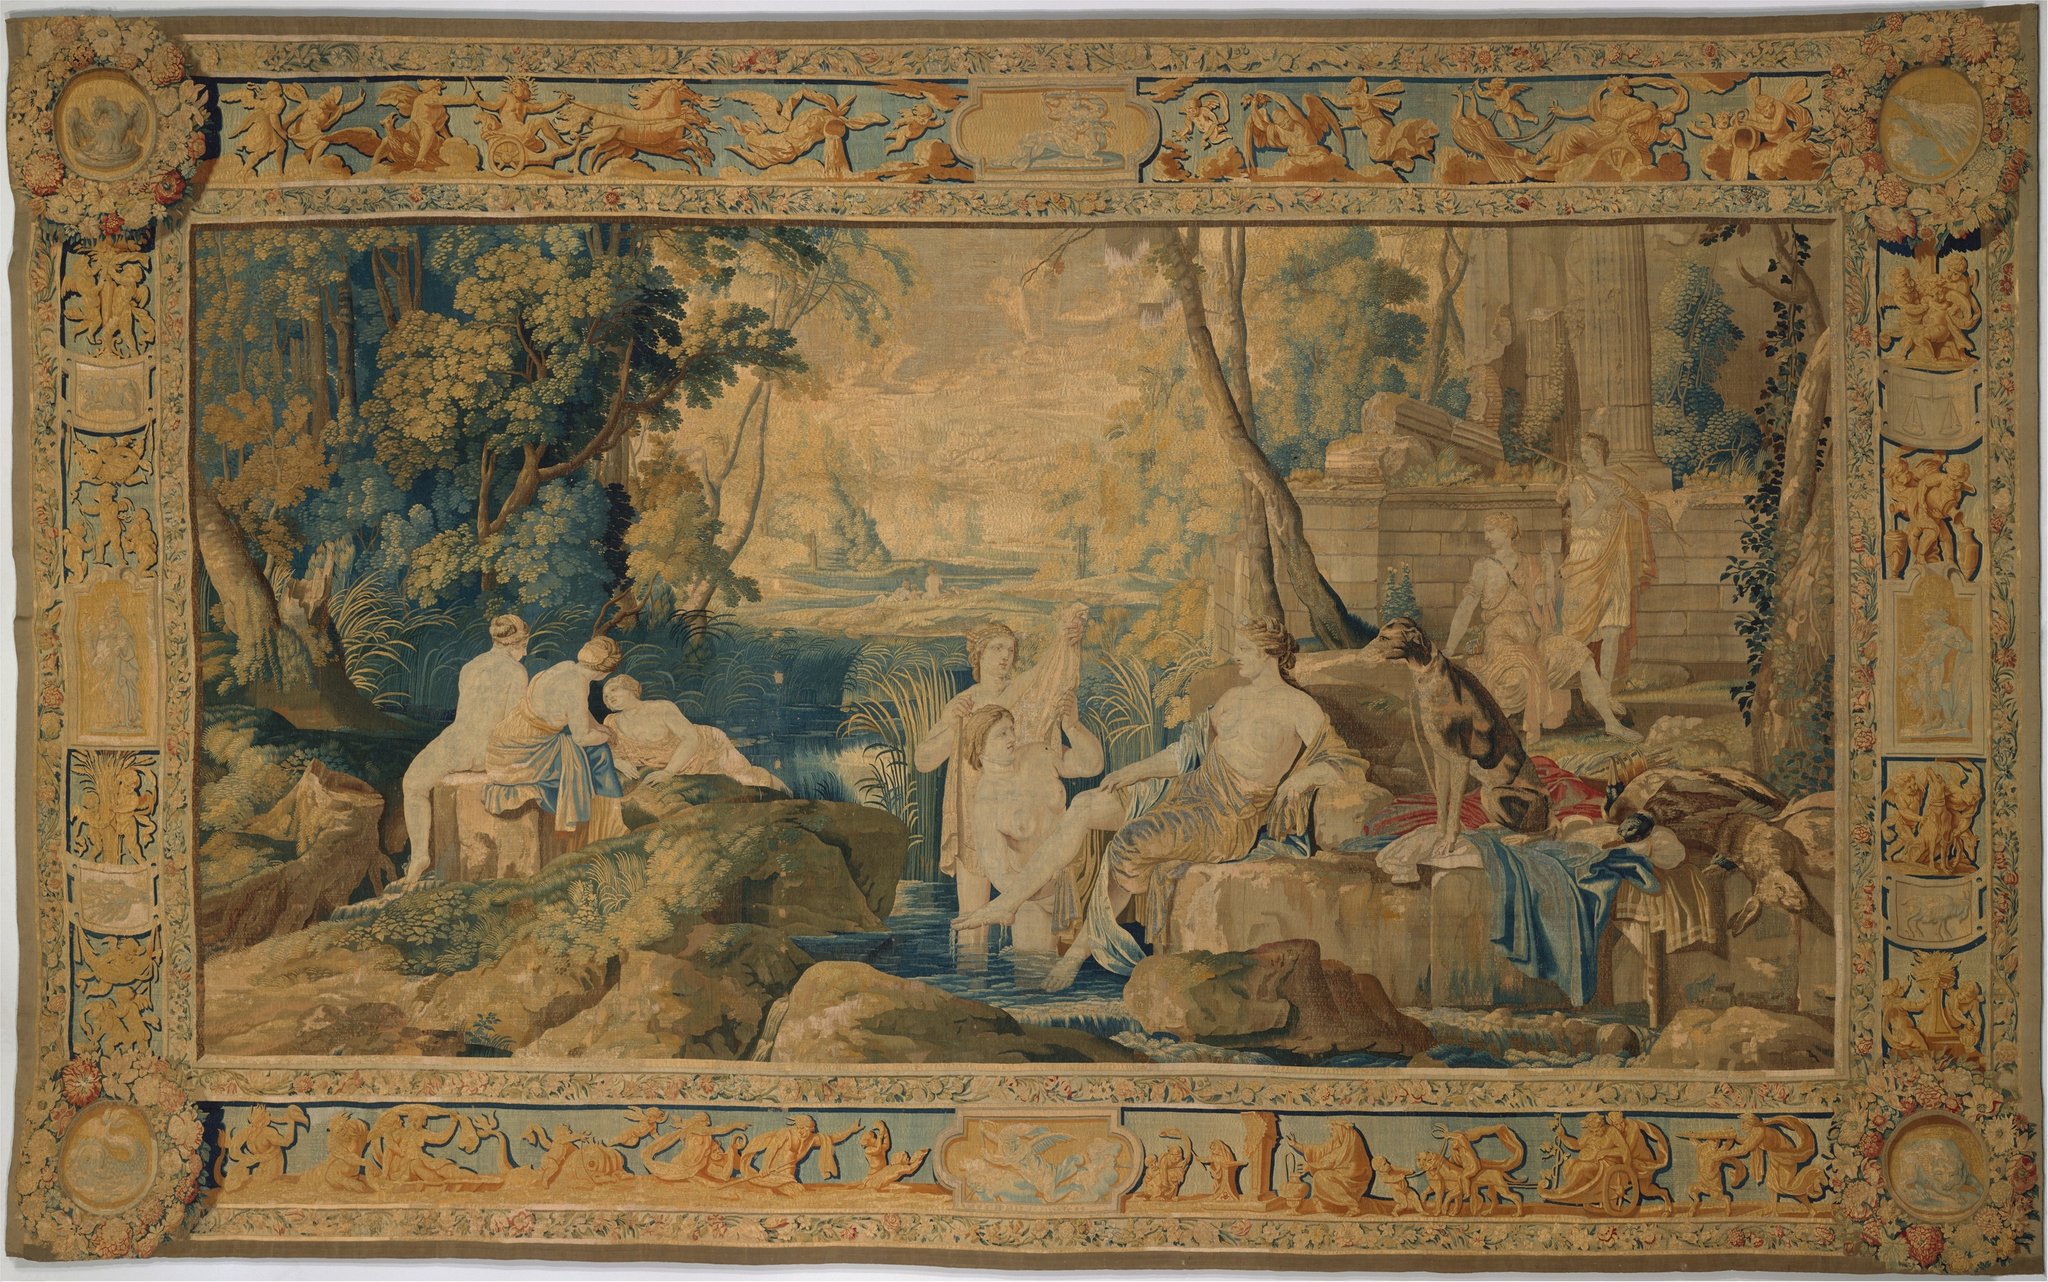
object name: tapestry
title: Diana and her Nymphs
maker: laurent de la hyre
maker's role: artist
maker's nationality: french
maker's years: 1606-1656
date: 1662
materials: silk, silver gilt, thread, wool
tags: female nudes,nymphs,diana,dogs,bathing